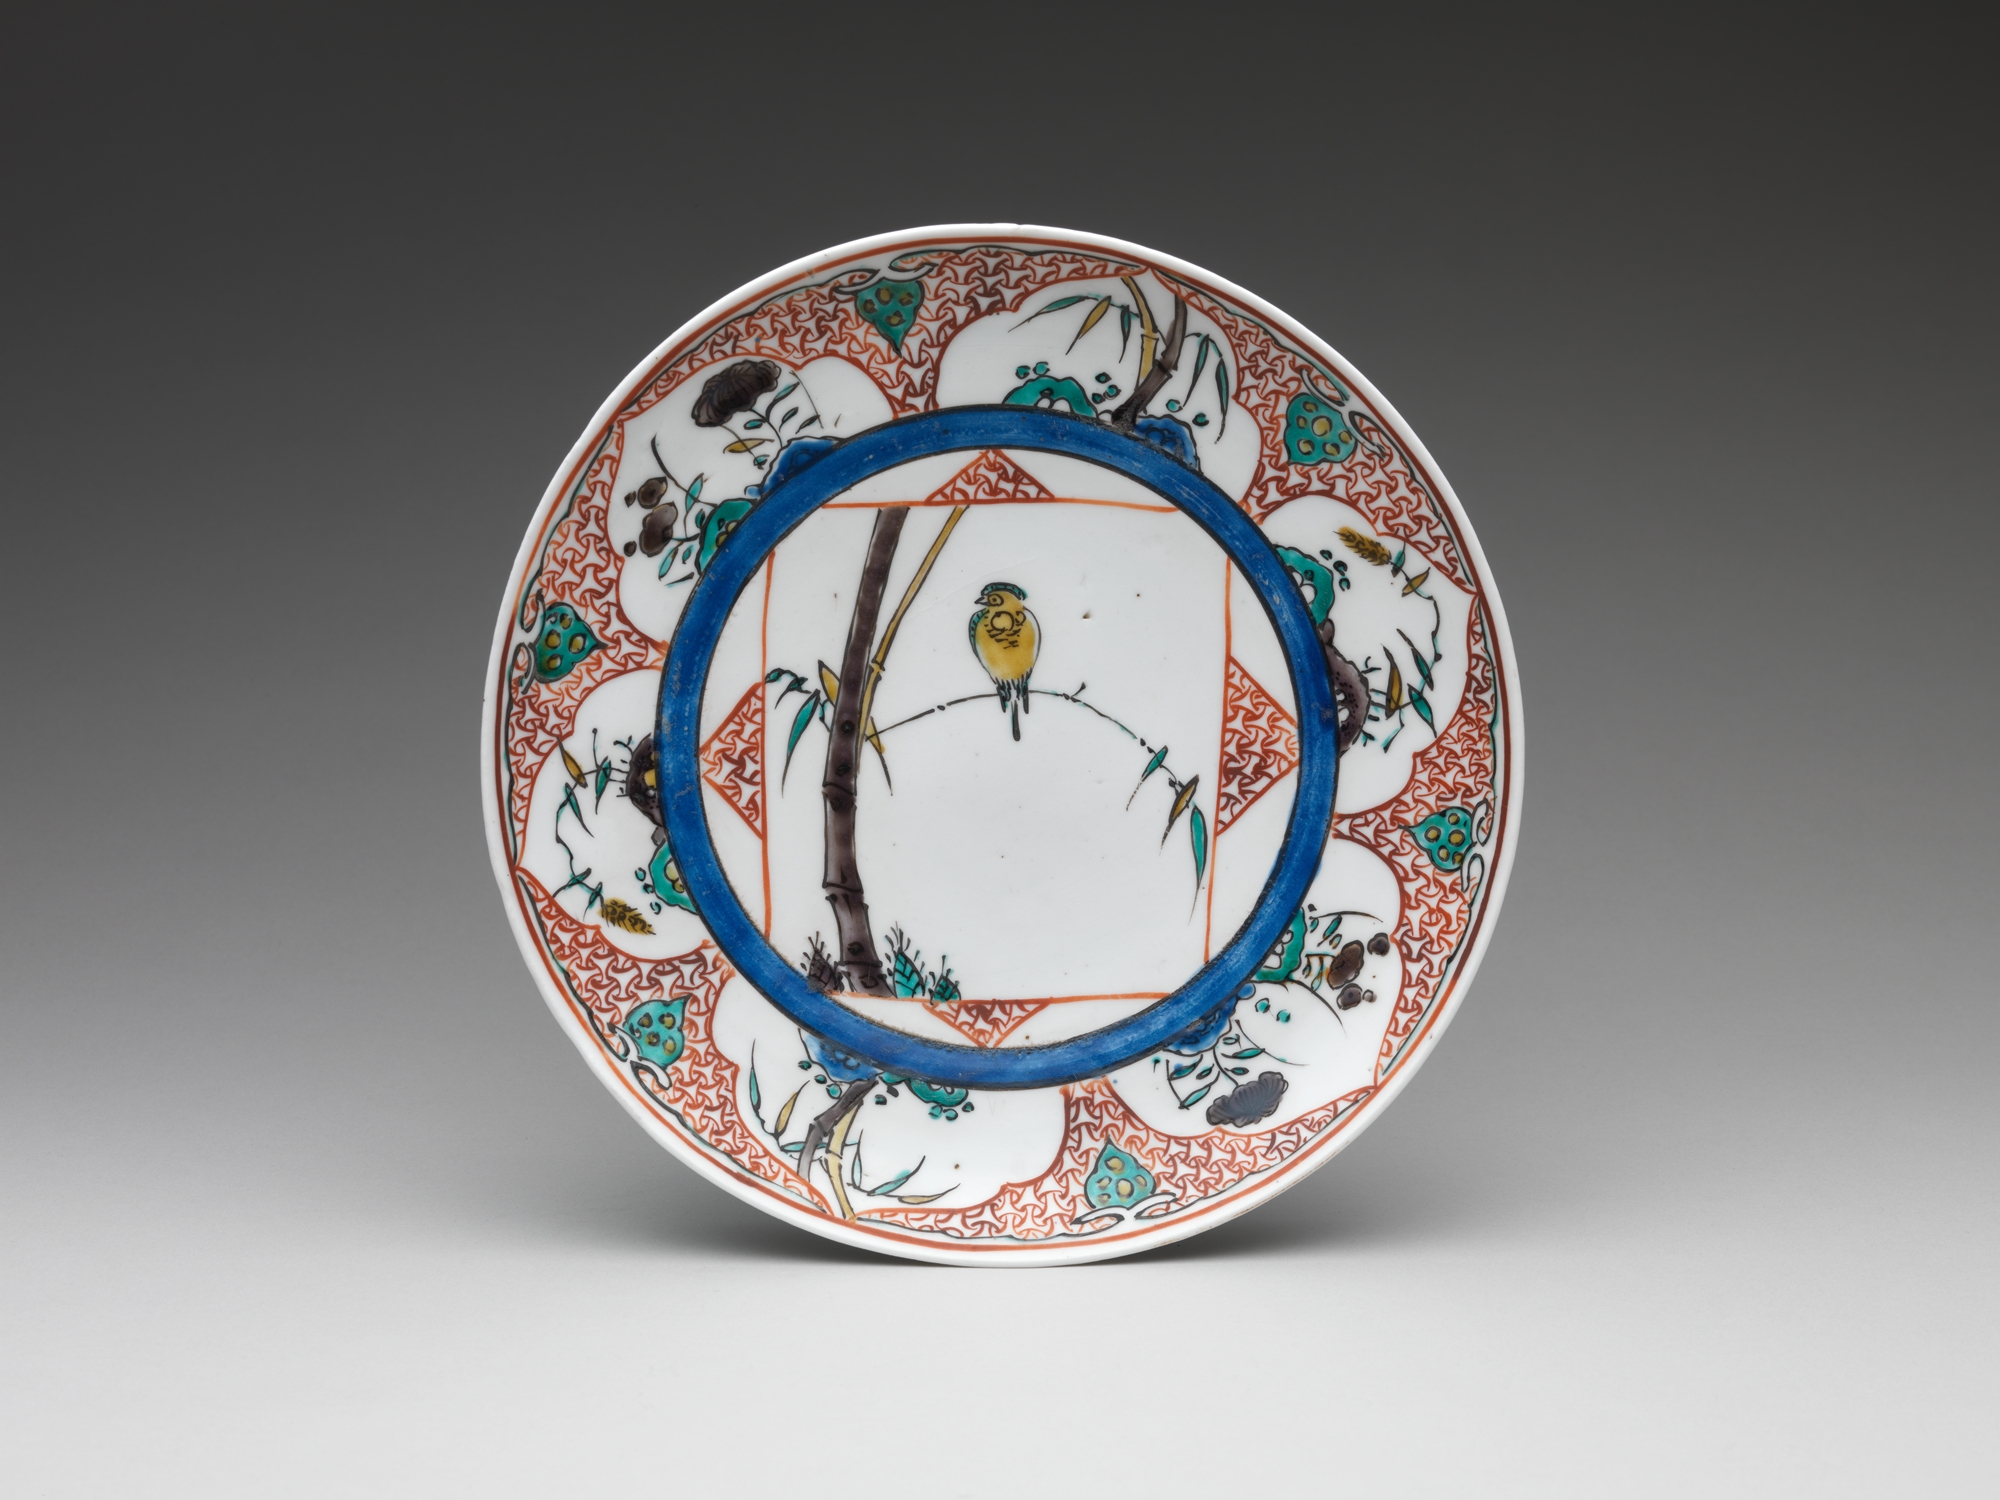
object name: dish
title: Dish with Bird on Bamboo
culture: japanese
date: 1700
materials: enamel, porcelain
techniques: overglaze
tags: birds,flowers,bamboo